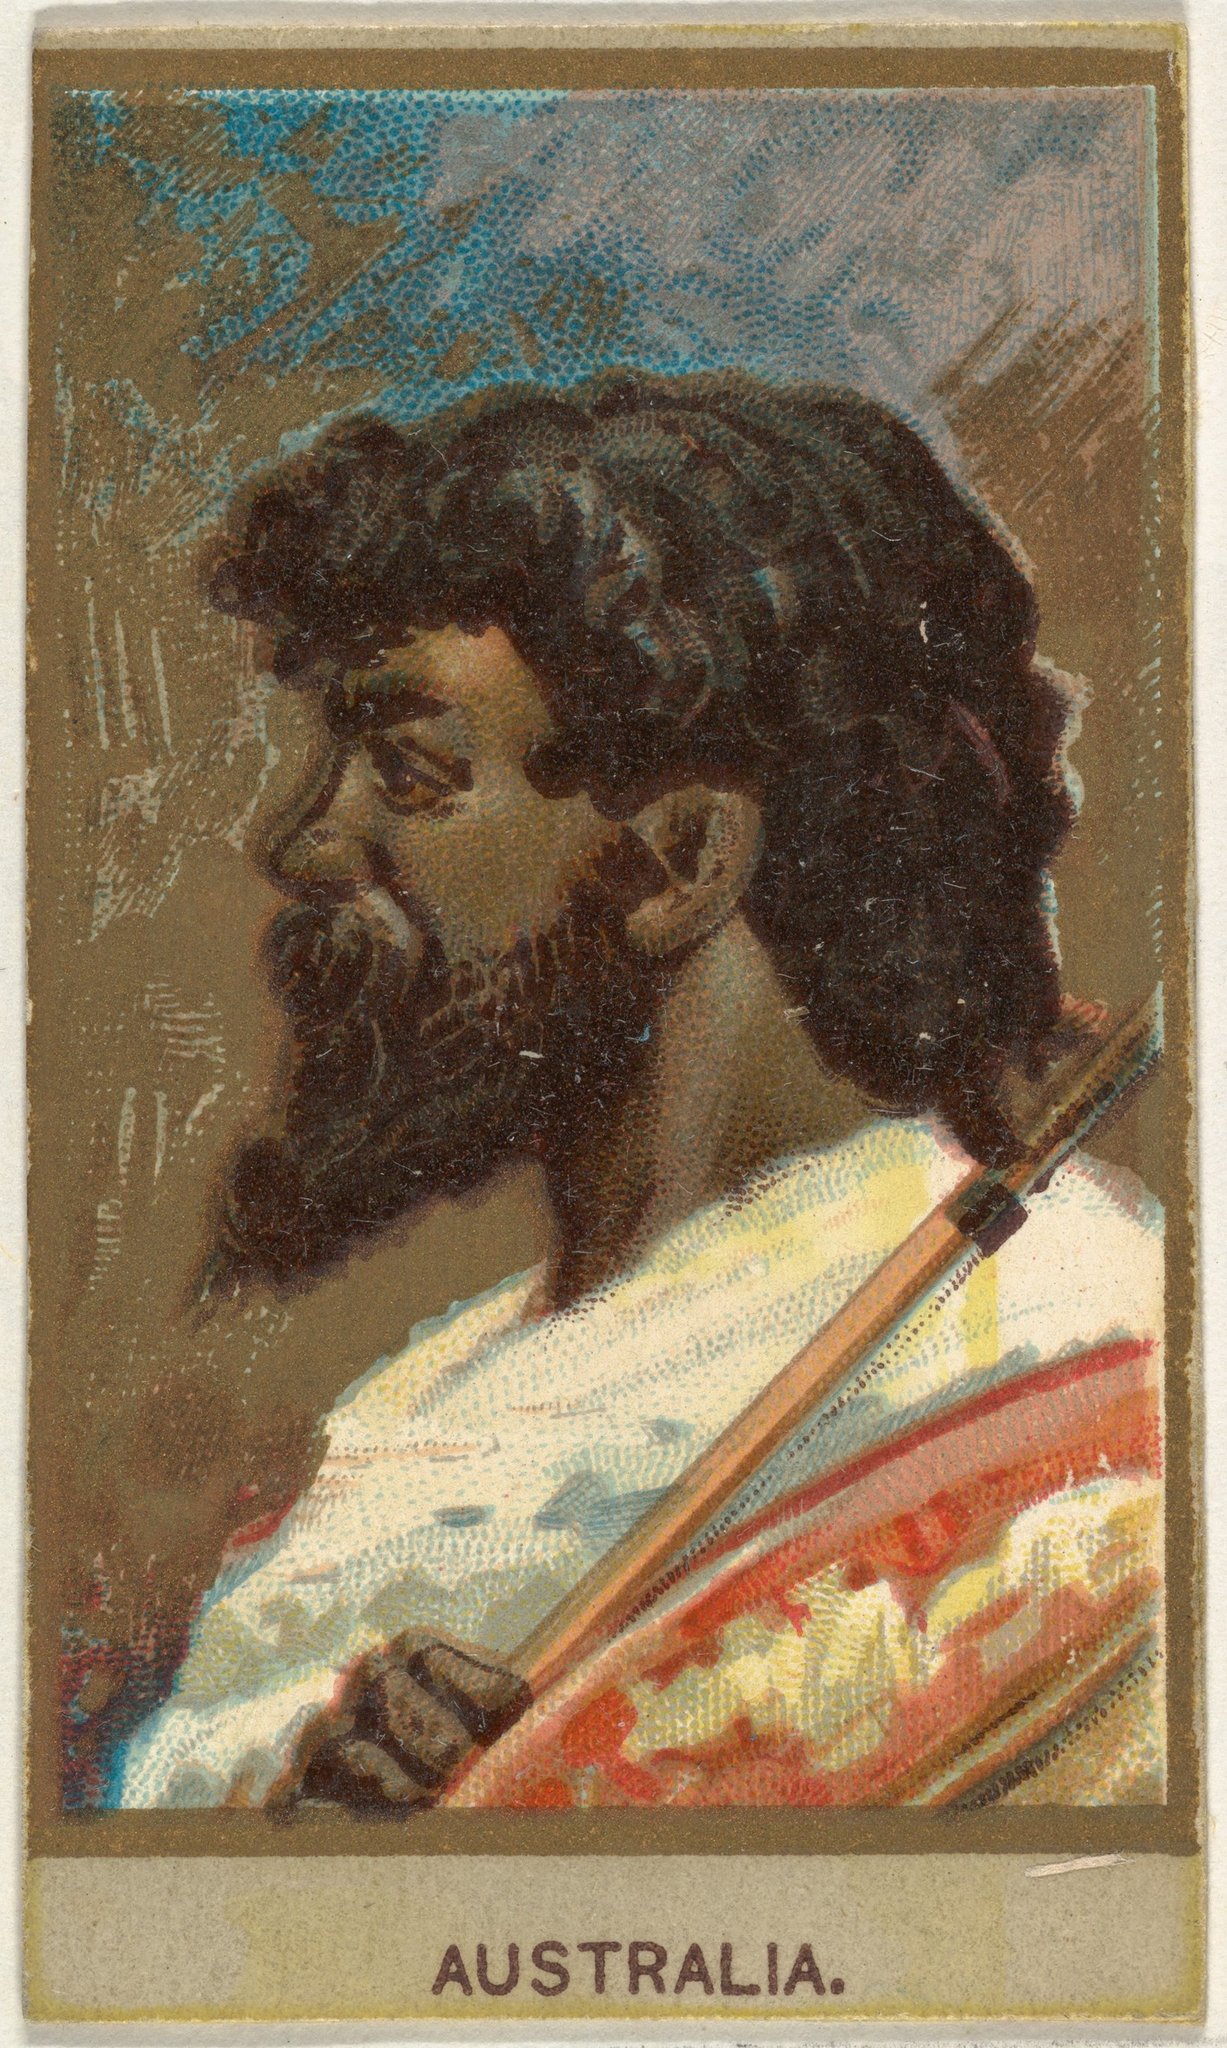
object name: print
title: Australia, from the Races of Mankind series (T181) issued by Abdul Cigarettes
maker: abdul cigarettes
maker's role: publisher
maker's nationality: american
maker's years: 1881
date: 1881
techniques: color lithograph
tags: men,profiles